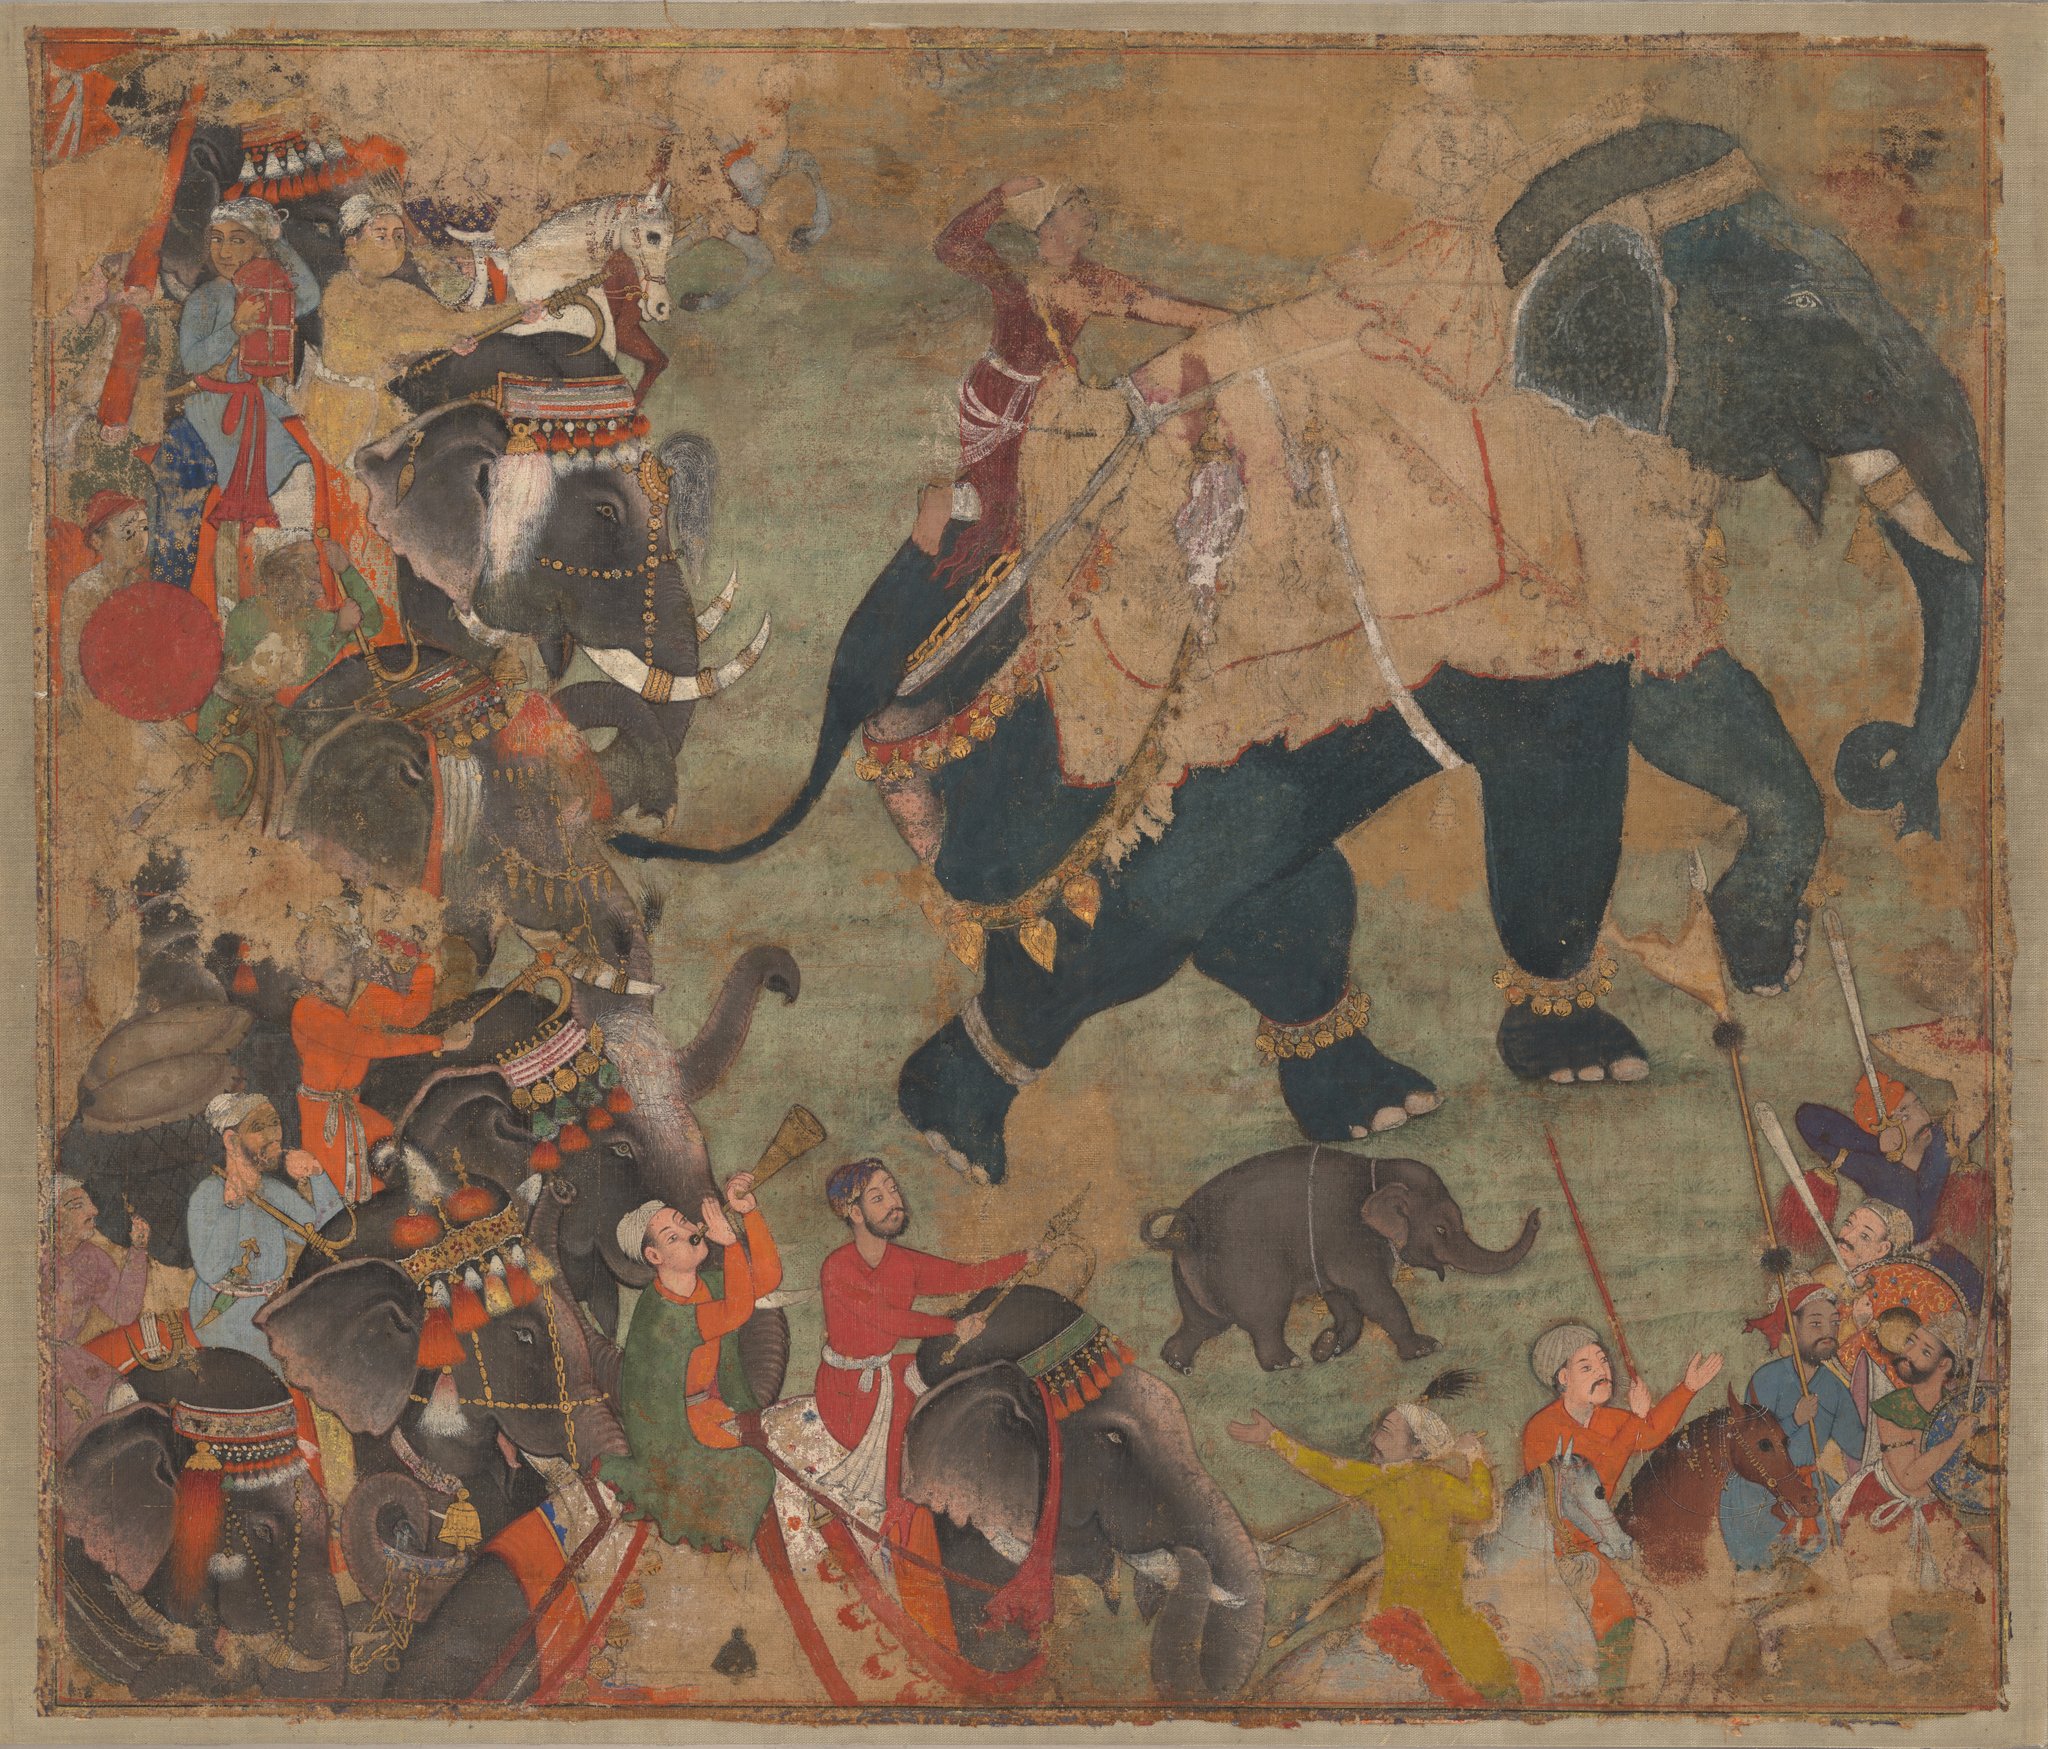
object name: painting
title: A Prince Riding an Elephant in Procession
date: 1570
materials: textile, cotton, gold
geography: india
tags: elephants,horses